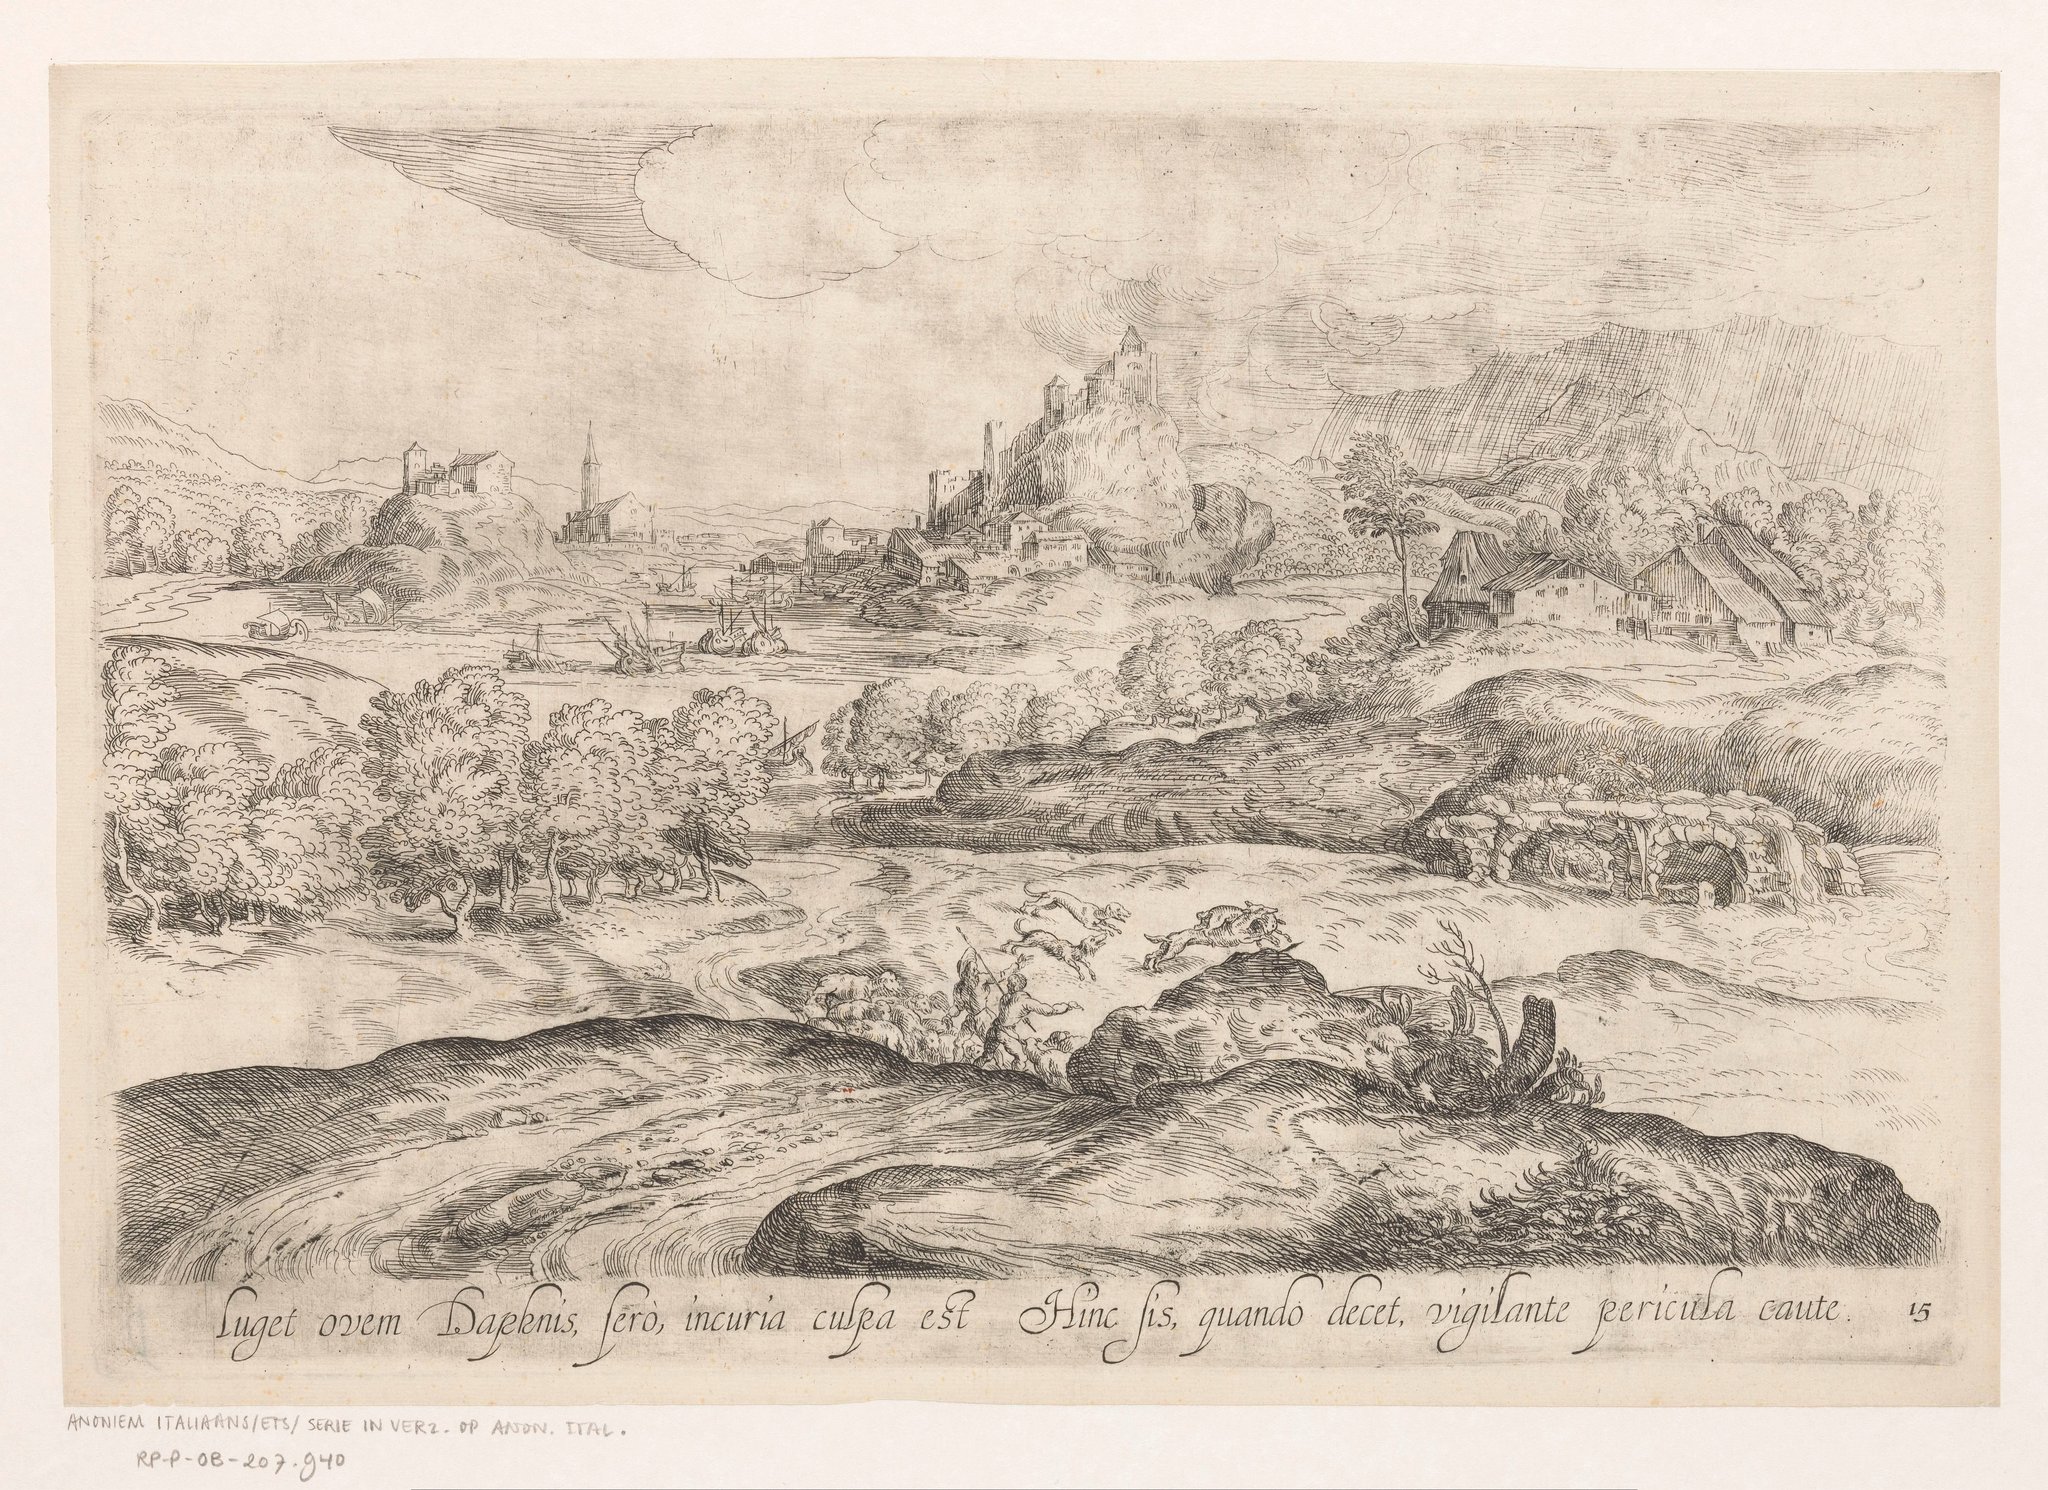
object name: print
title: Landschappen naar Domenico Campagnola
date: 1600-1699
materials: paper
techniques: etching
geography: italy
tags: landscapes, herding, herdsman, herdswoman, shepherd, shepherdess, cowherd, etc., herd, flock, beasts of prey, predatory animals: wolf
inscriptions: collector's mark: Lugt 2228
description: Landschap met heuvels en een rivier. Op de voorgrond twee herders met hun kudde schapen. Een wolf valt de kudde aan. Titel in het Latijn in ondermarge. Genummerd rechtsonder: 15.